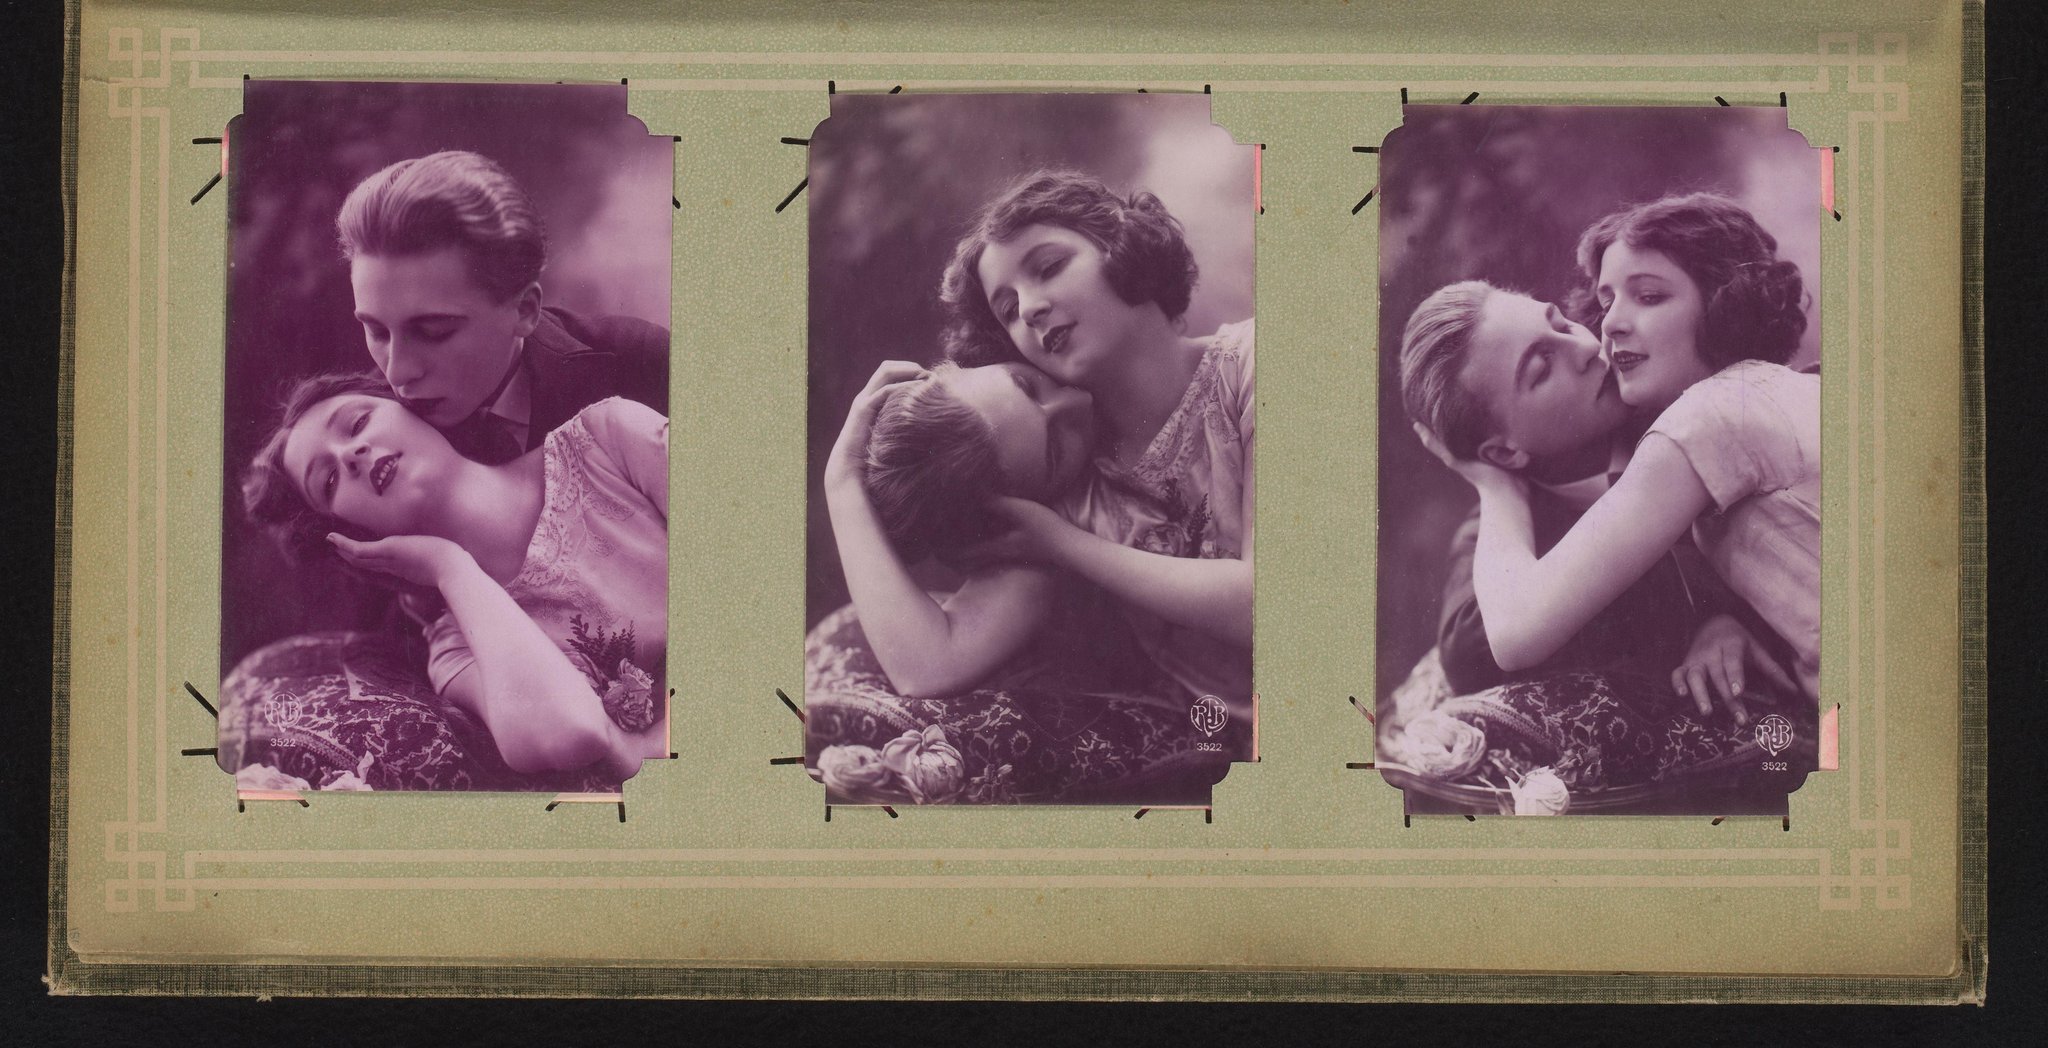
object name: album leaf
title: Drie portretten van een paar geliefden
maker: Anonymous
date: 1900-1930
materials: cardboard, photographic support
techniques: gelatin silver print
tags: historical persons - bb - woman, (lovers) kissing each other, historical persons, couple of lovers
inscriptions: monogram: ‘RTB’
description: Deze foto's maken deel uit van een album.